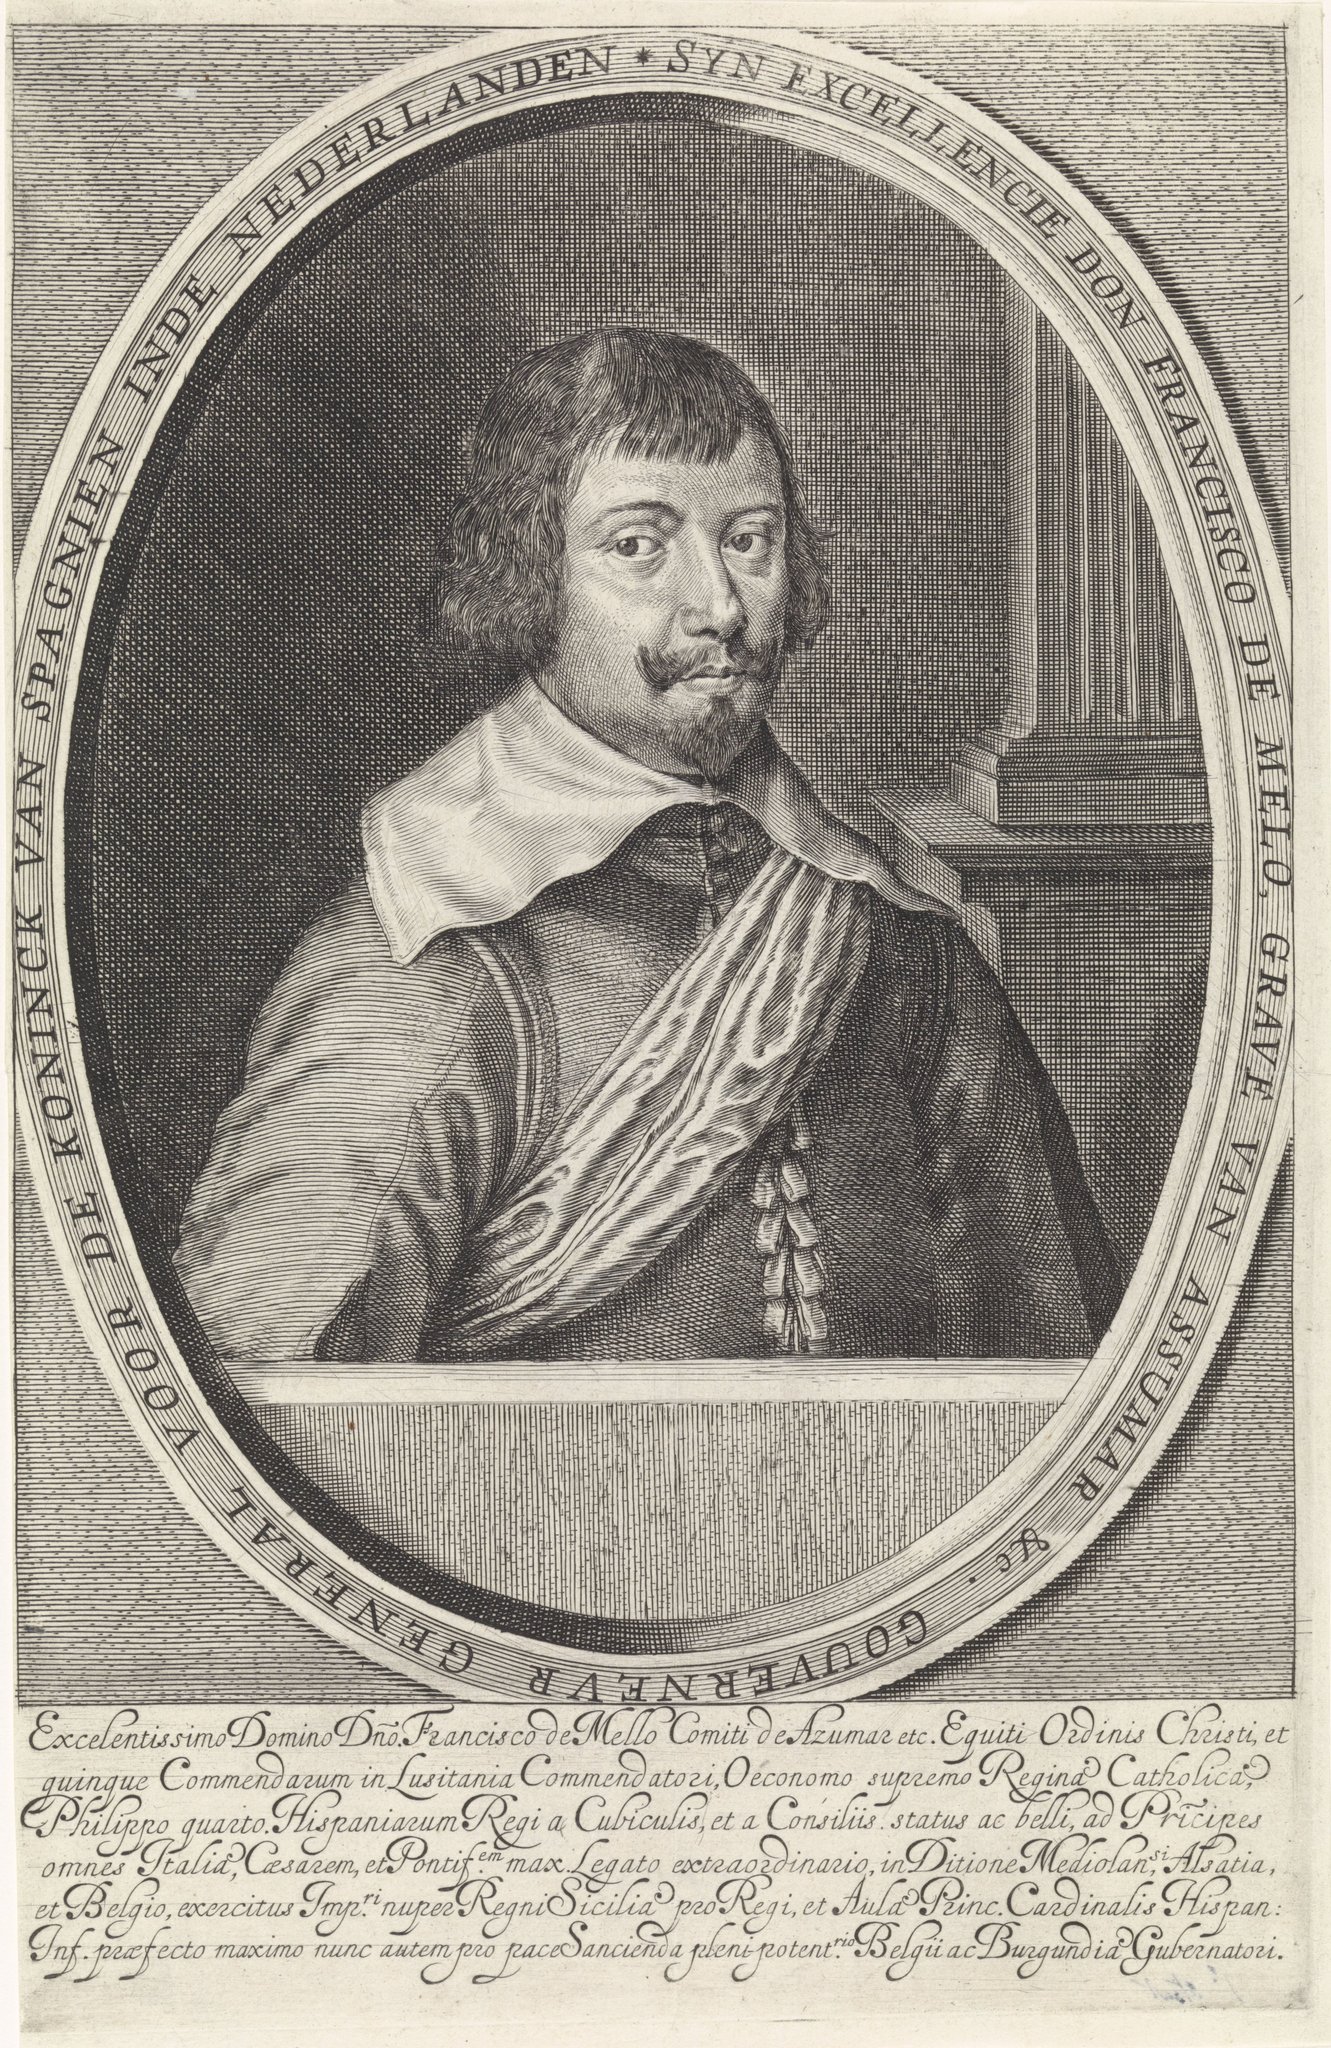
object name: print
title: Portret van Francisco de Melo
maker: crispijn van de passe (ii)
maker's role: draughtsman, print maker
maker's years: 1594-1670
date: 1604-1670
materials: paper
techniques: engraving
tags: landvoogd, francisco de melo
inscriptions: inscription: ‘1e staat’, collector's mark: Lugt 2228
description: Portret van Francisco de Melo, graaf van Assumar, en landvoogd van de Zuidelijke Nederlanden. In het randschrift van de omlijsting de naam en functie van de geportretteerde in het Nederlands. In de marge een zesregelig onderschrift in het Latijn.